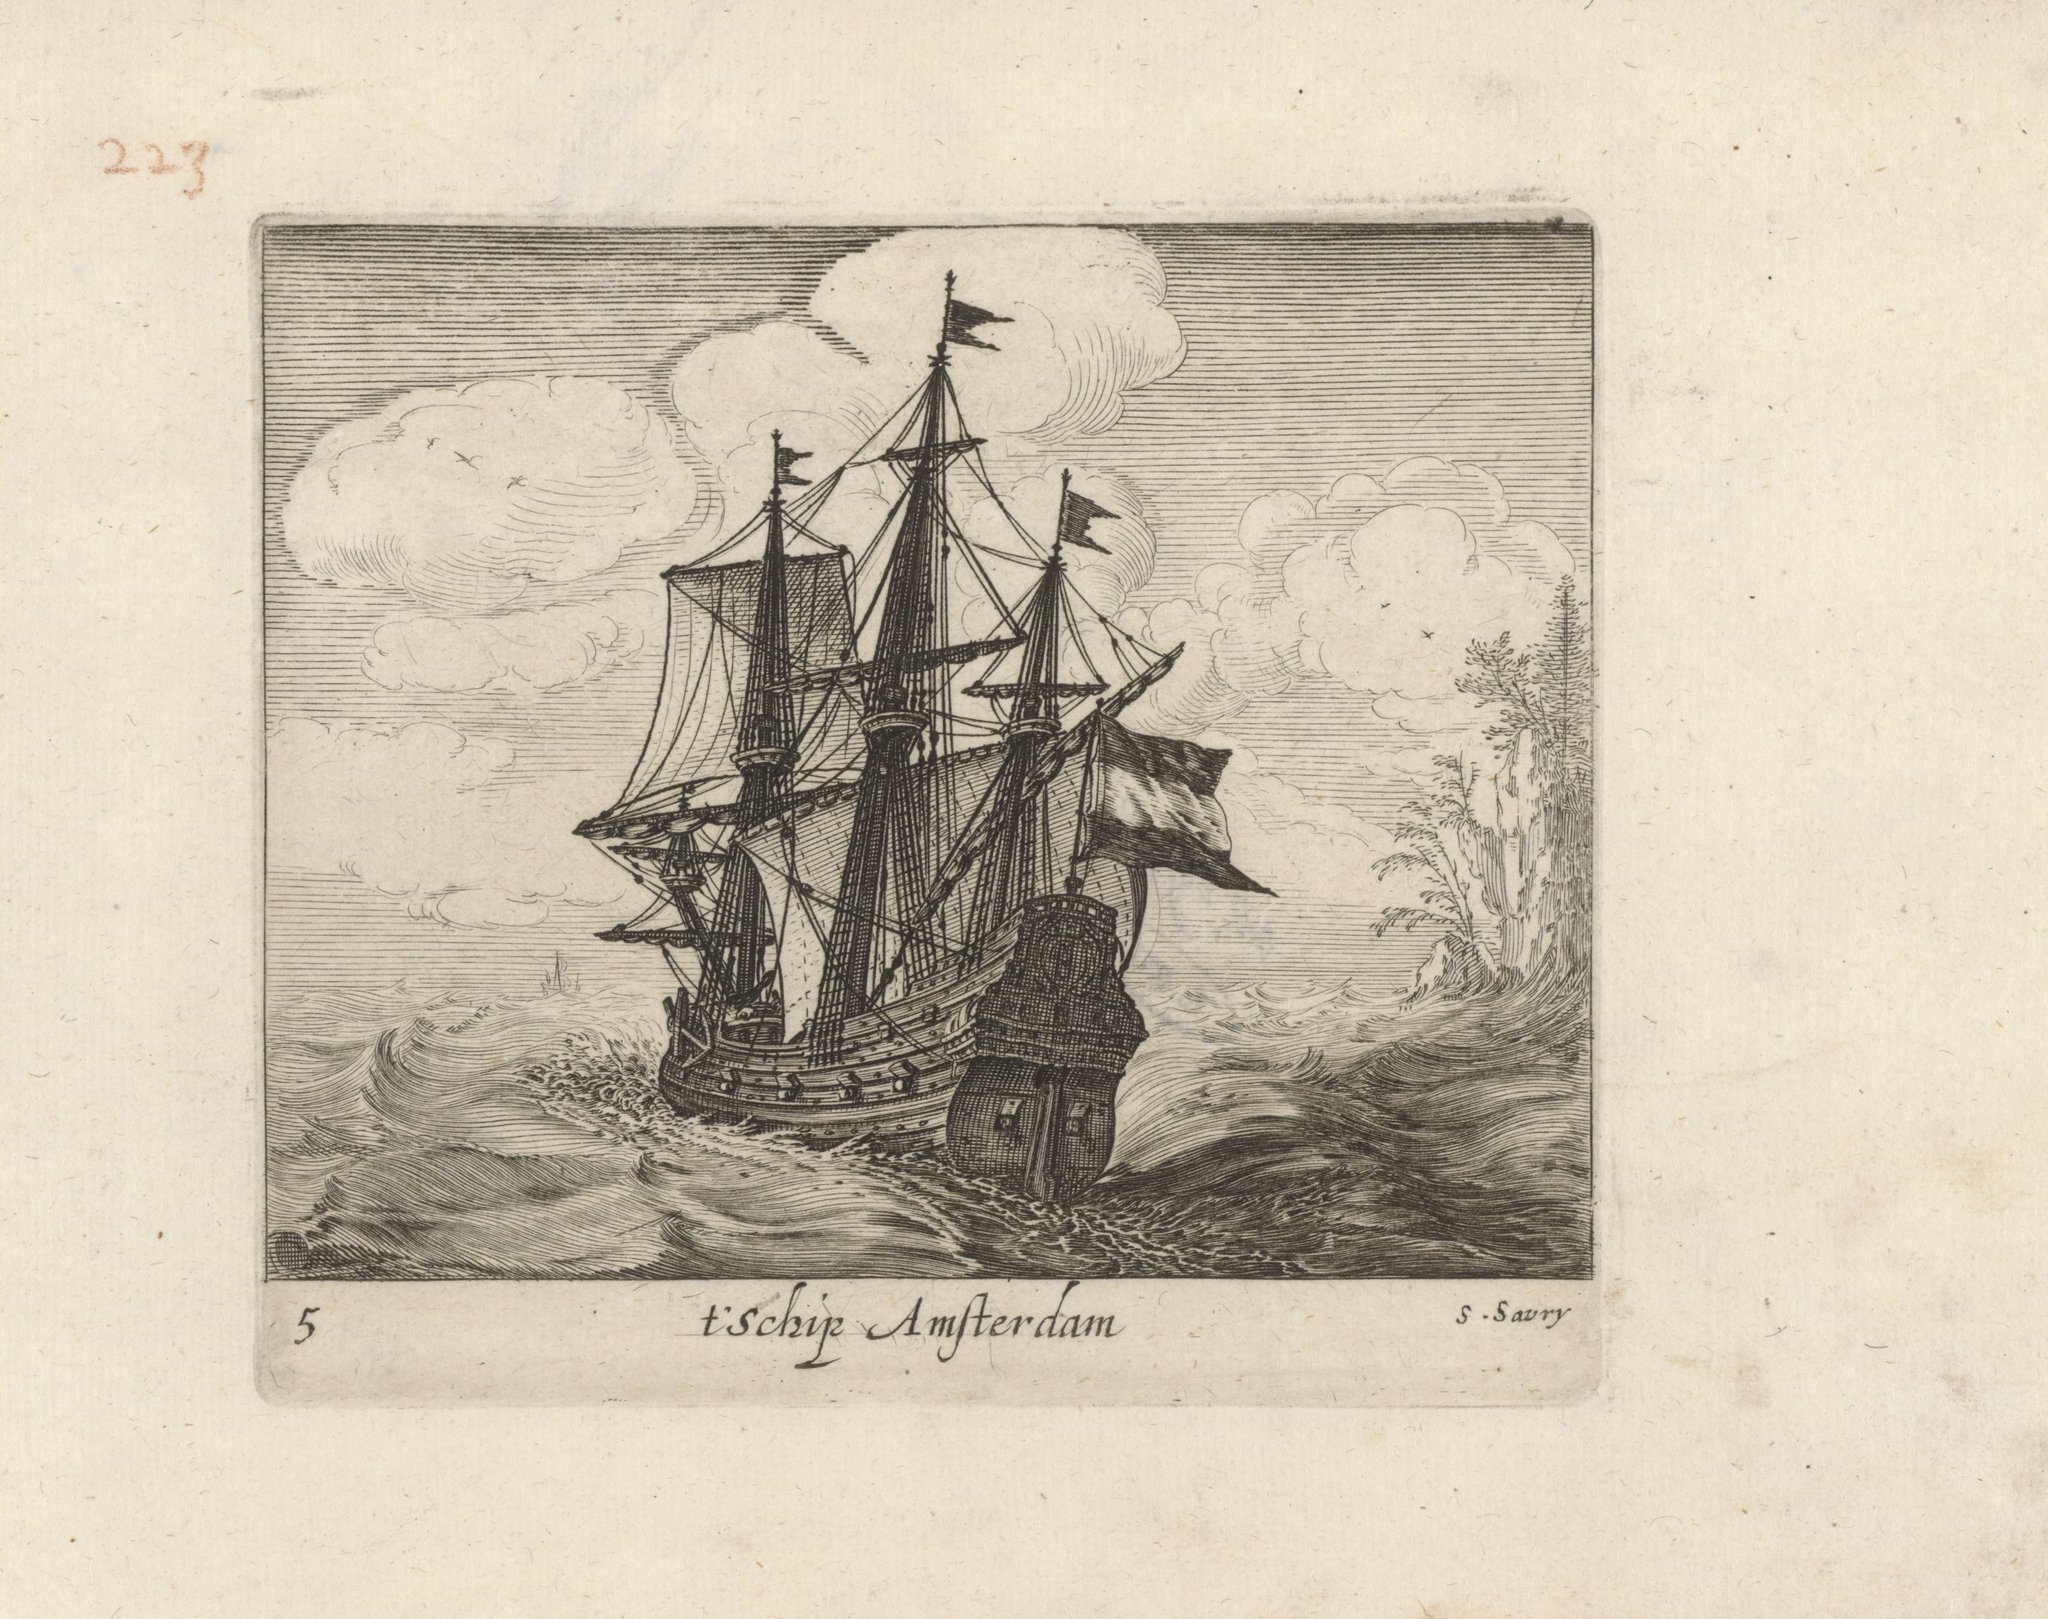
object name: print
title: Driemaster op zee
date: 1610-1665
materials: paper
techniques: engraving, etching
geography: amsterdam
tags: sailing-ship, sailing-boat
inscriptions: number: ‘223’, collector's mark: Lugt 2228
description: De prent maakt deel uit van een zesdelige serie met voorstellingen van verschillende zeilschepen.